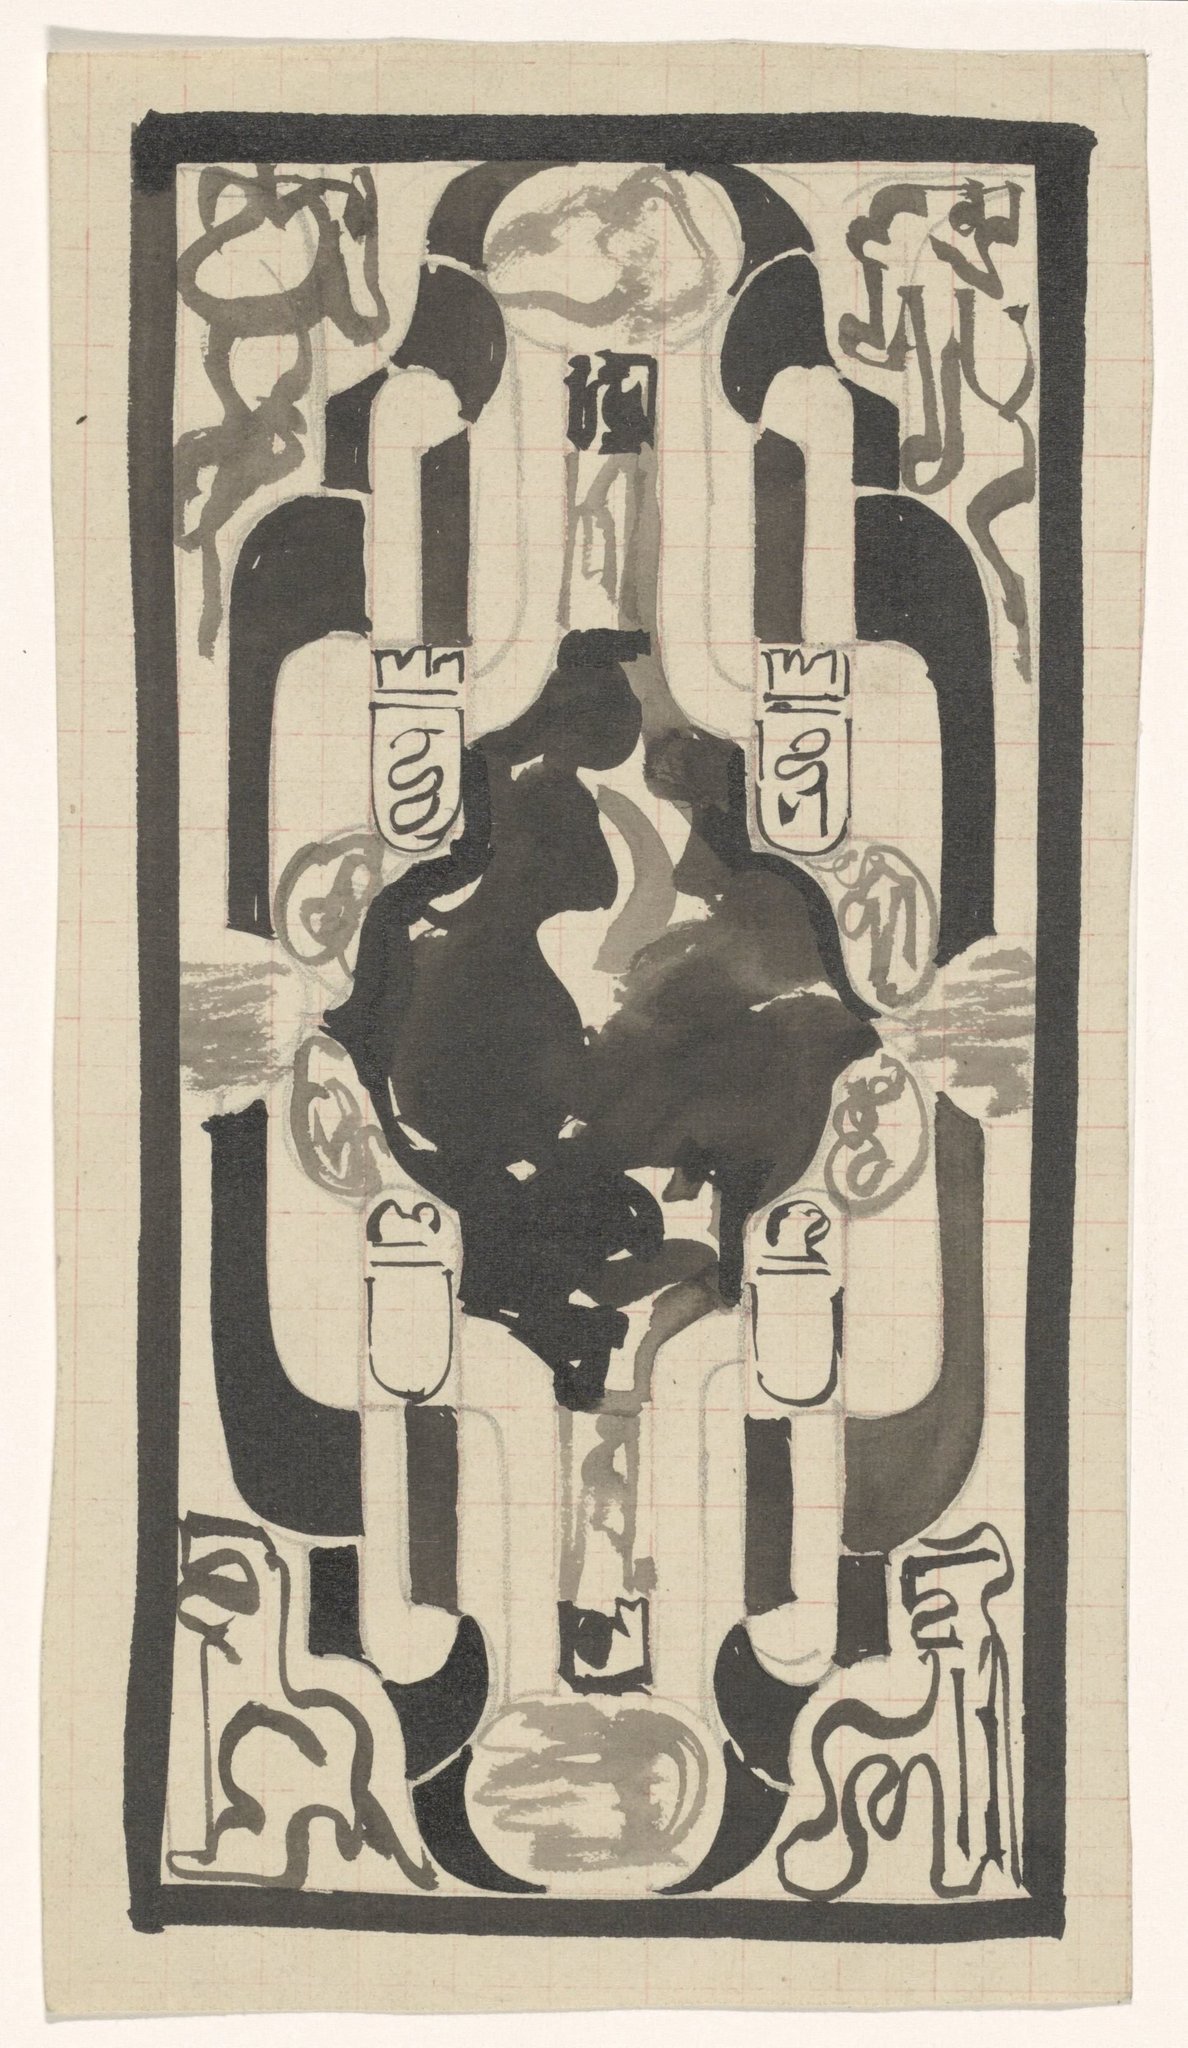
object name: design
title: Decoratief ontwerp met vier wapenschilden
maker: carel adolph lion cachet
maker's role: draughtsman, print maker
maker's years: 1864-1945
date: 1874-1945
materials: pencil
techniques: brush